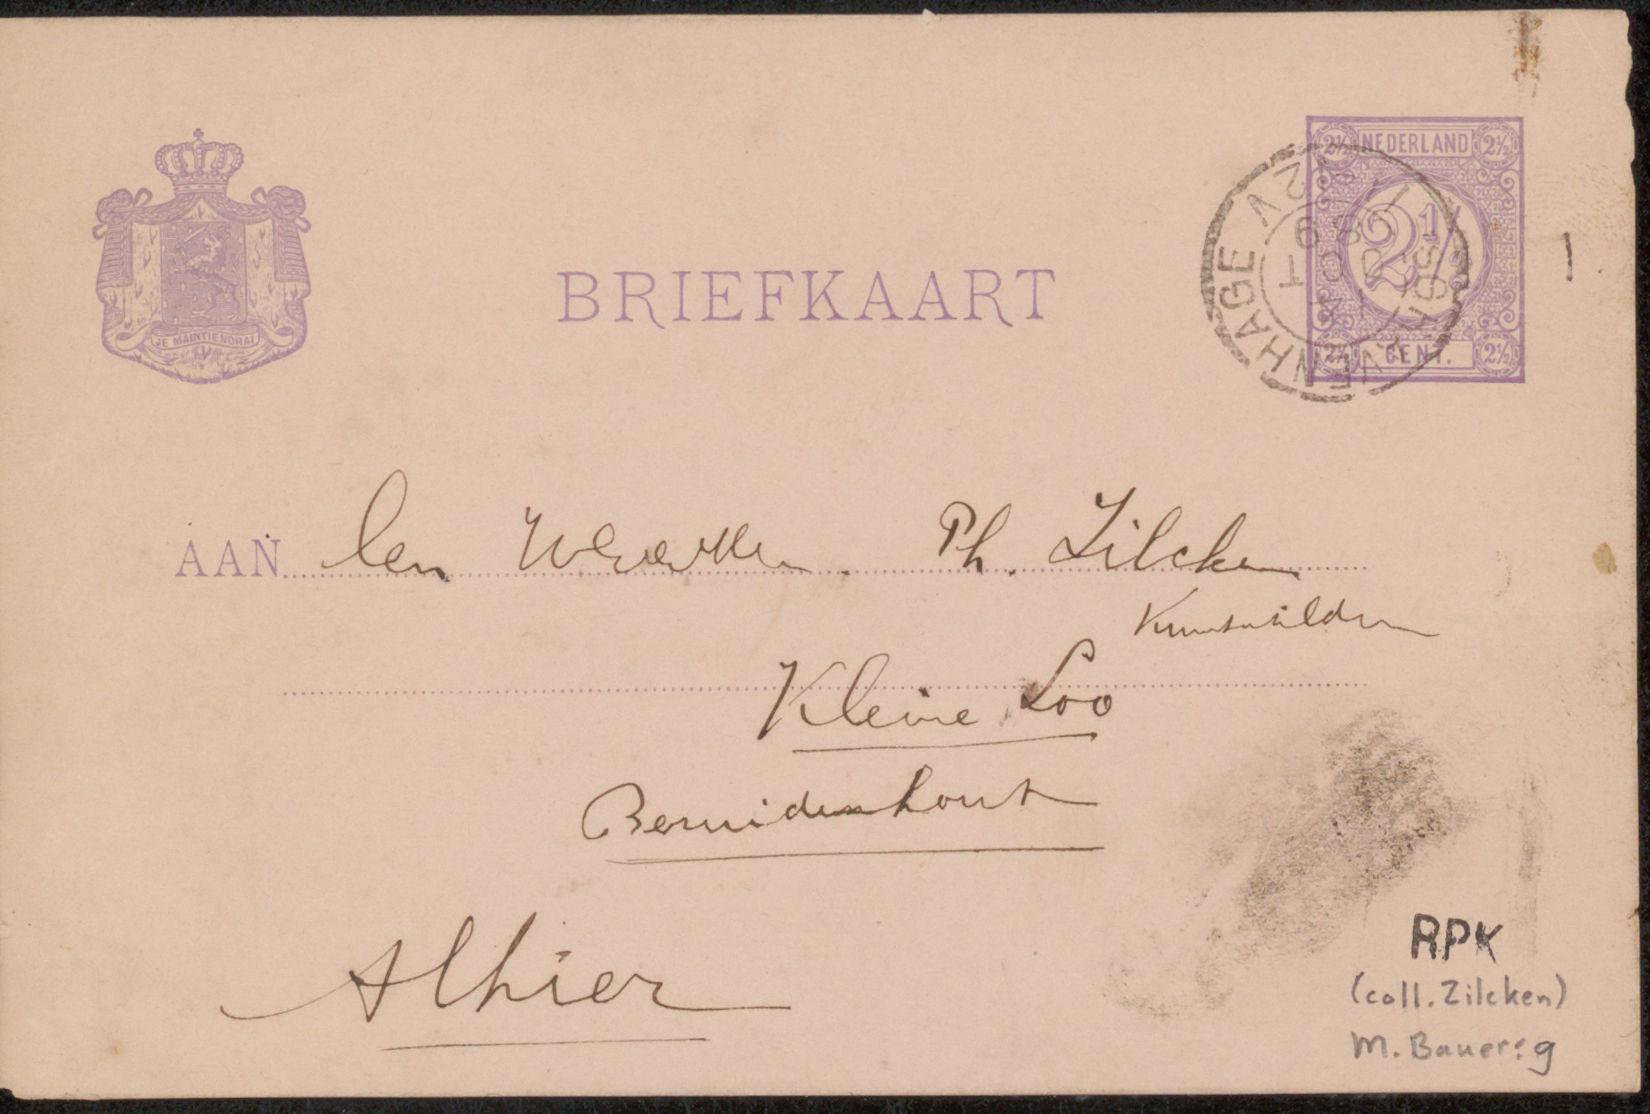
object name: postcard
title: Briefkaart aan Philip Zilcken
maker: marius bauer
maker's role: draughtsman, print maker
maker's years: 1867-1932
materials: cardboard, ink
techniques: pen, writing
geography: the hague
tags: painter, philip zilcken, etching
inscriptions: collector's mark: ‘RPK’